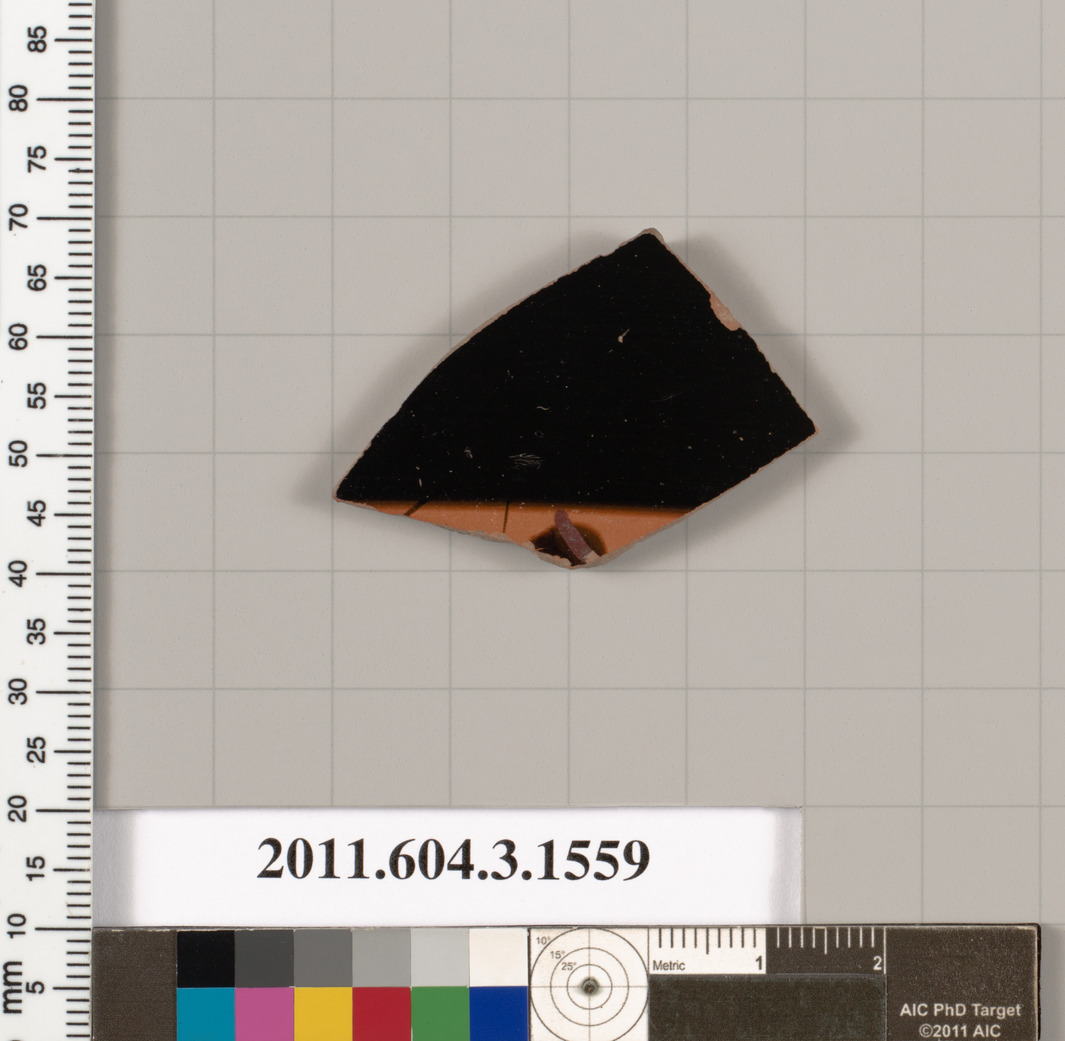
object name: kylix fragment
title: Terracotta fragment of a kylix: Band cup (drinking cup)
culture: greek, attic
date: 550-526 BCE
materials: terracotta